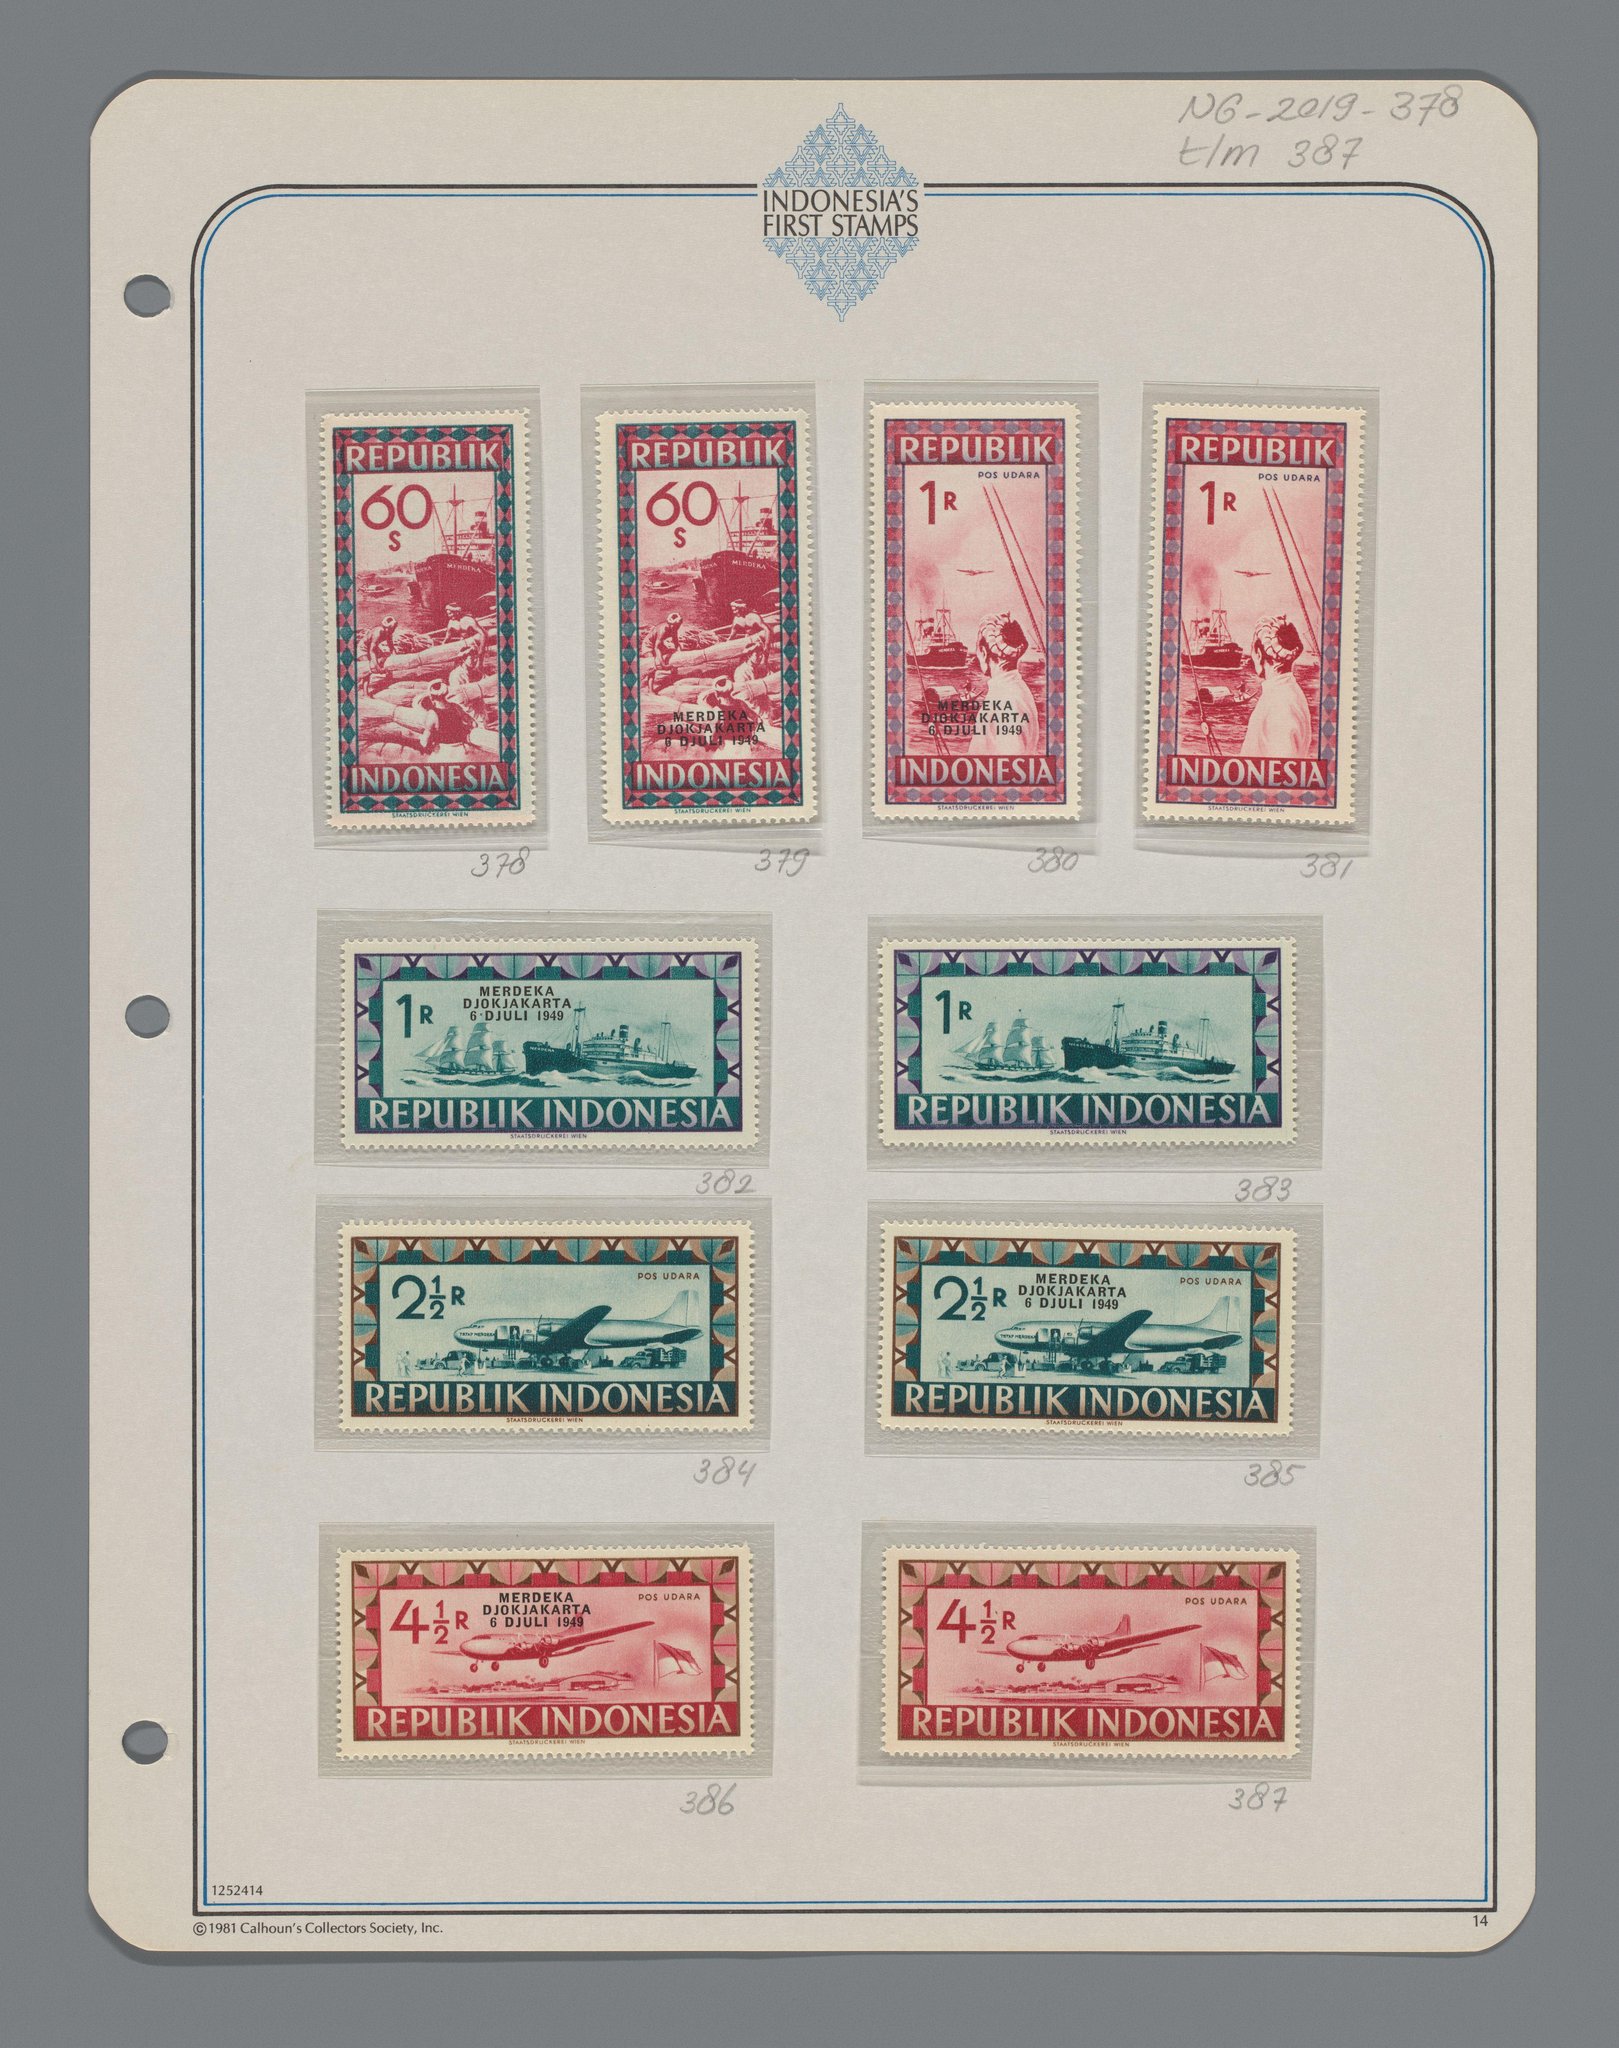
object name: postage stamp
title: Postzegel Republik Indonesia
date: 1949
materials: paper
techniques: photoaquatint, engraving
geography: vienna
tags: indonesia